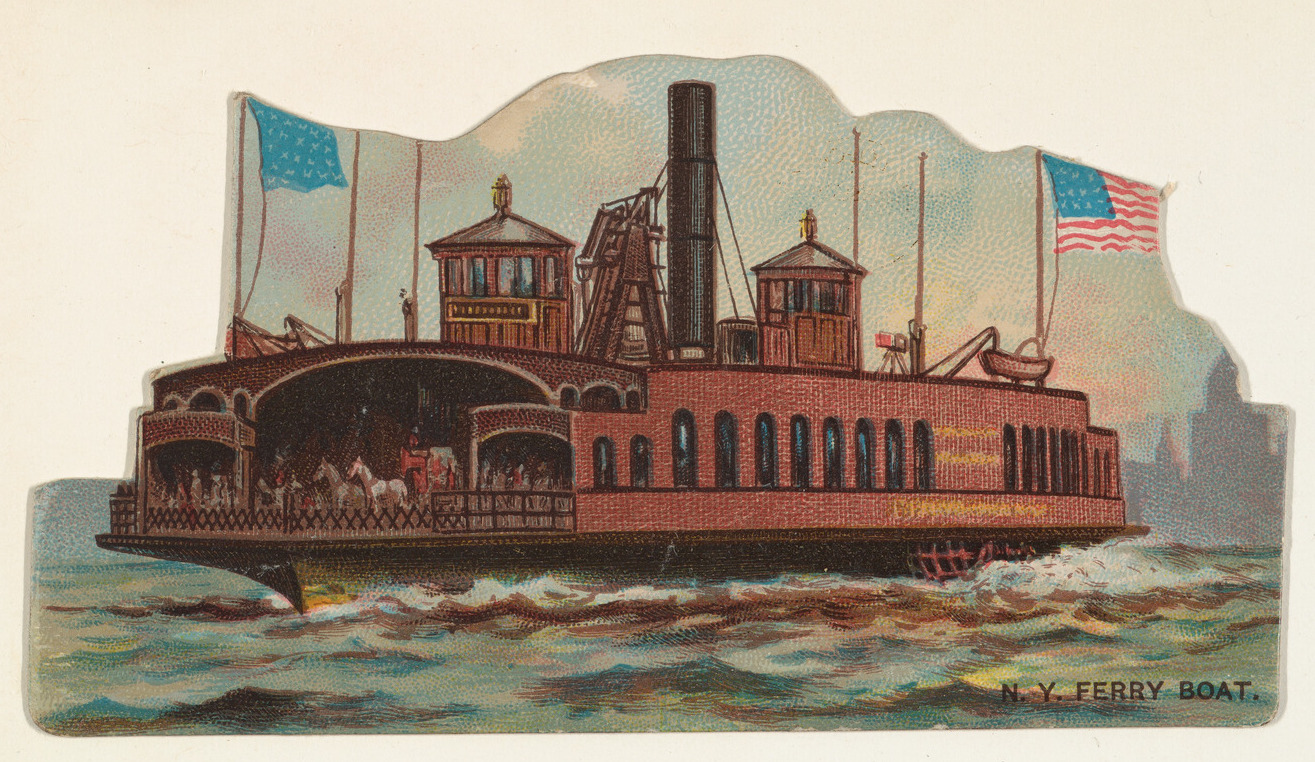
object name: print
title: New York Ferry Boat, from the Types of Vessels series (N139) issued by Duke Sons & Co. to promote Honest Long Cut Tobacco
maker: w. duke, sons & co.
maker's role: publisher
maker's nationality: american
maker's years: 1870-1920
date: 1889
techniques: color lithograph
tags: boats